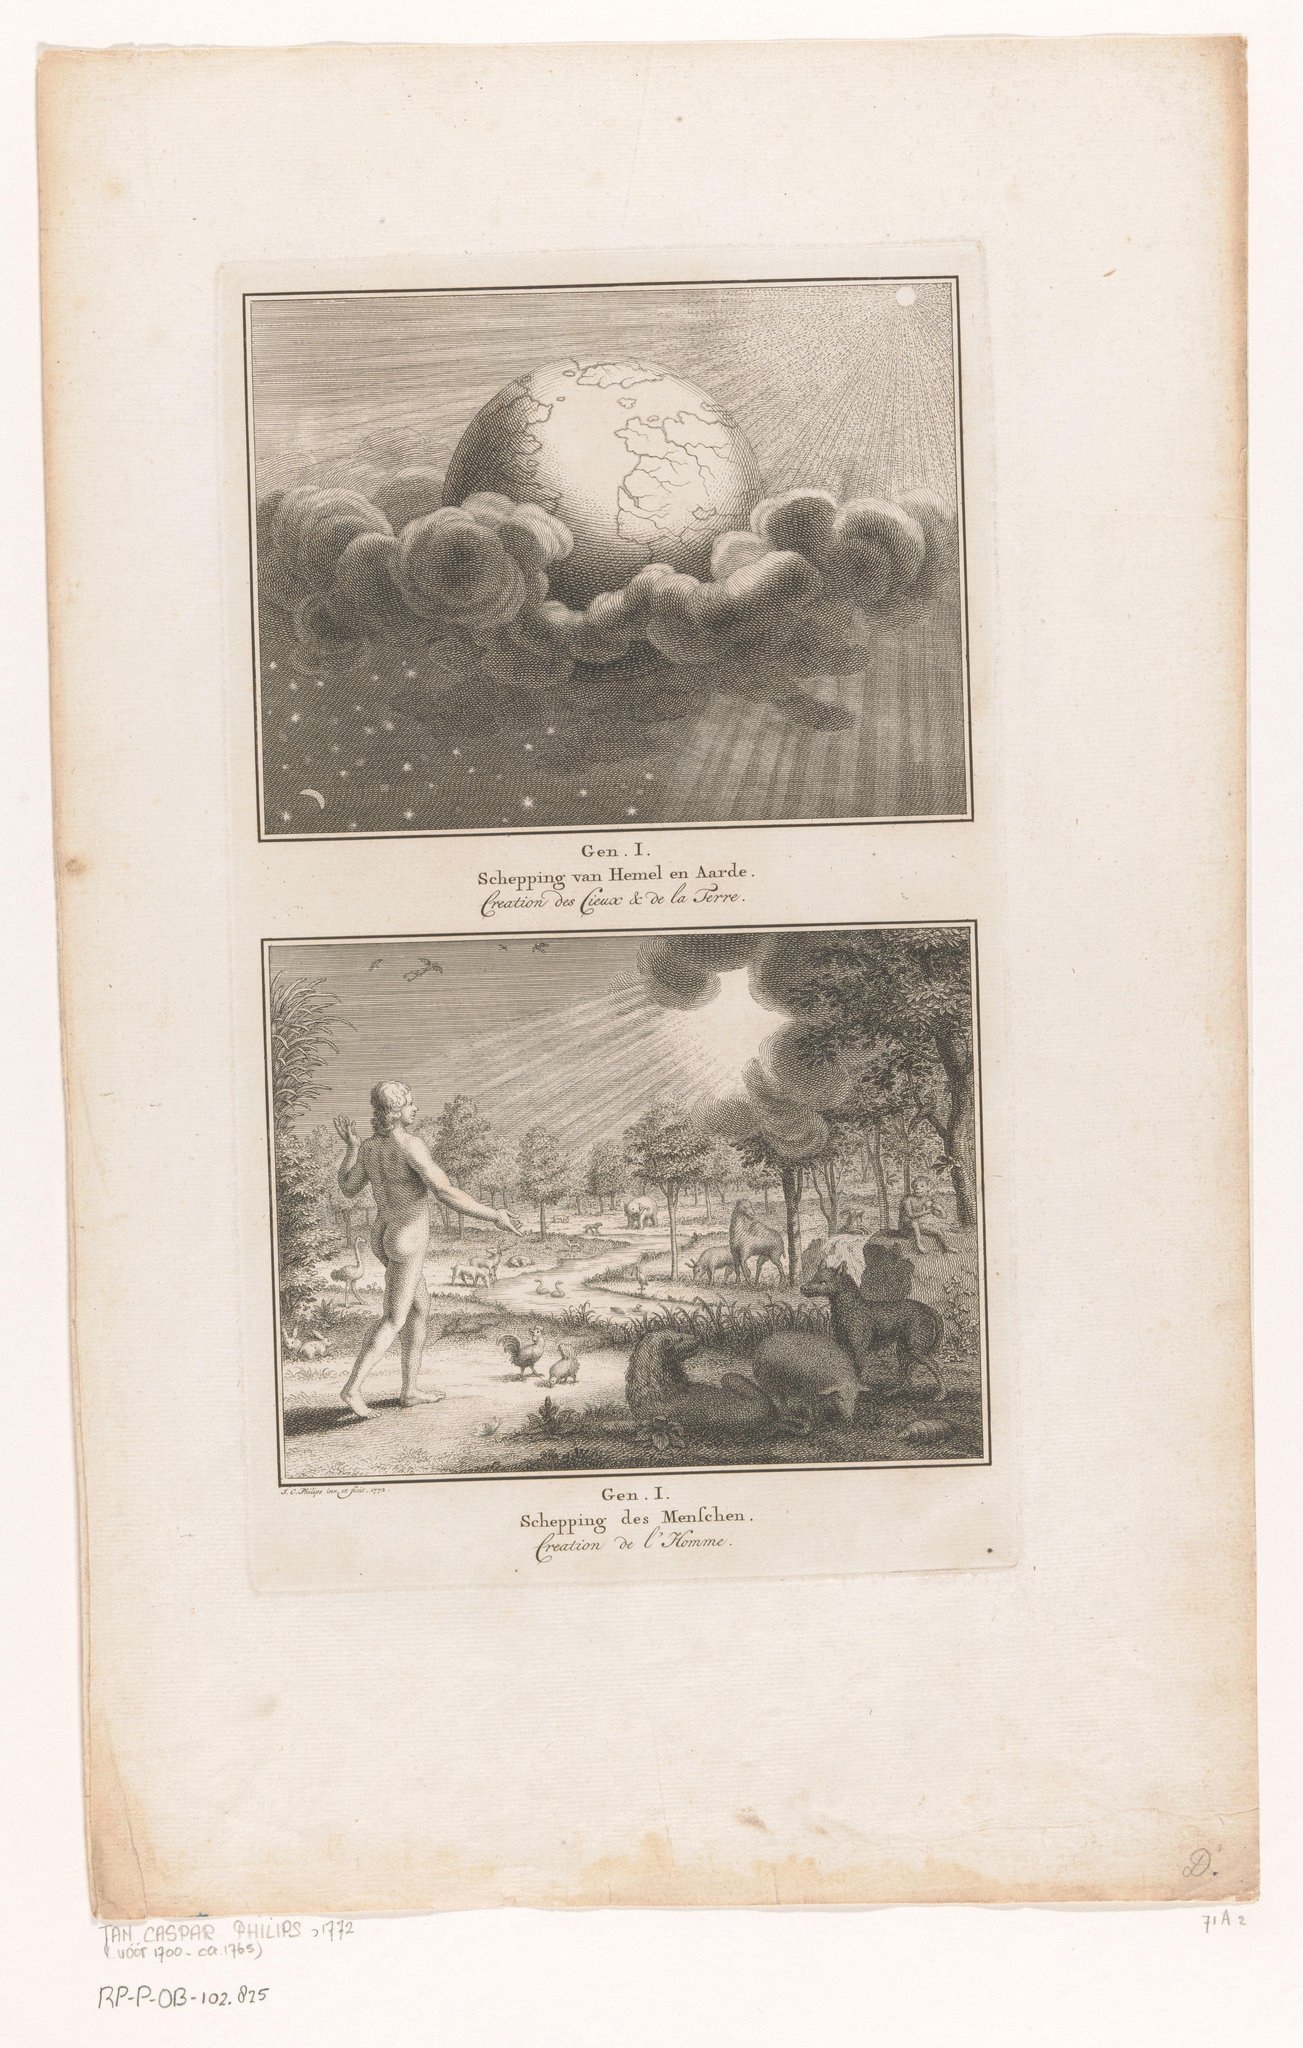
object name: print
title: De schepping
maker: jan caspar philips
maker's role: draughtsman, print maker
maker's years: 1700-1775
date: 1772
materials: paper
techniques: etching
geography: amsterdam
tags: god brings adam to paradise, creation of sun, moon and stars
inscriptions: collector's mark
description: Twee voorstellingen op één blad. Boven: de eerste dag van de schepping. God schept de hemel en de aarde en plaatst de wereldbol tussen de zon, de maan en de sterren. Onder: de zesde dag van de schepping. God schept Adam in het paradijs, waar hij wordt omringd door dieren.